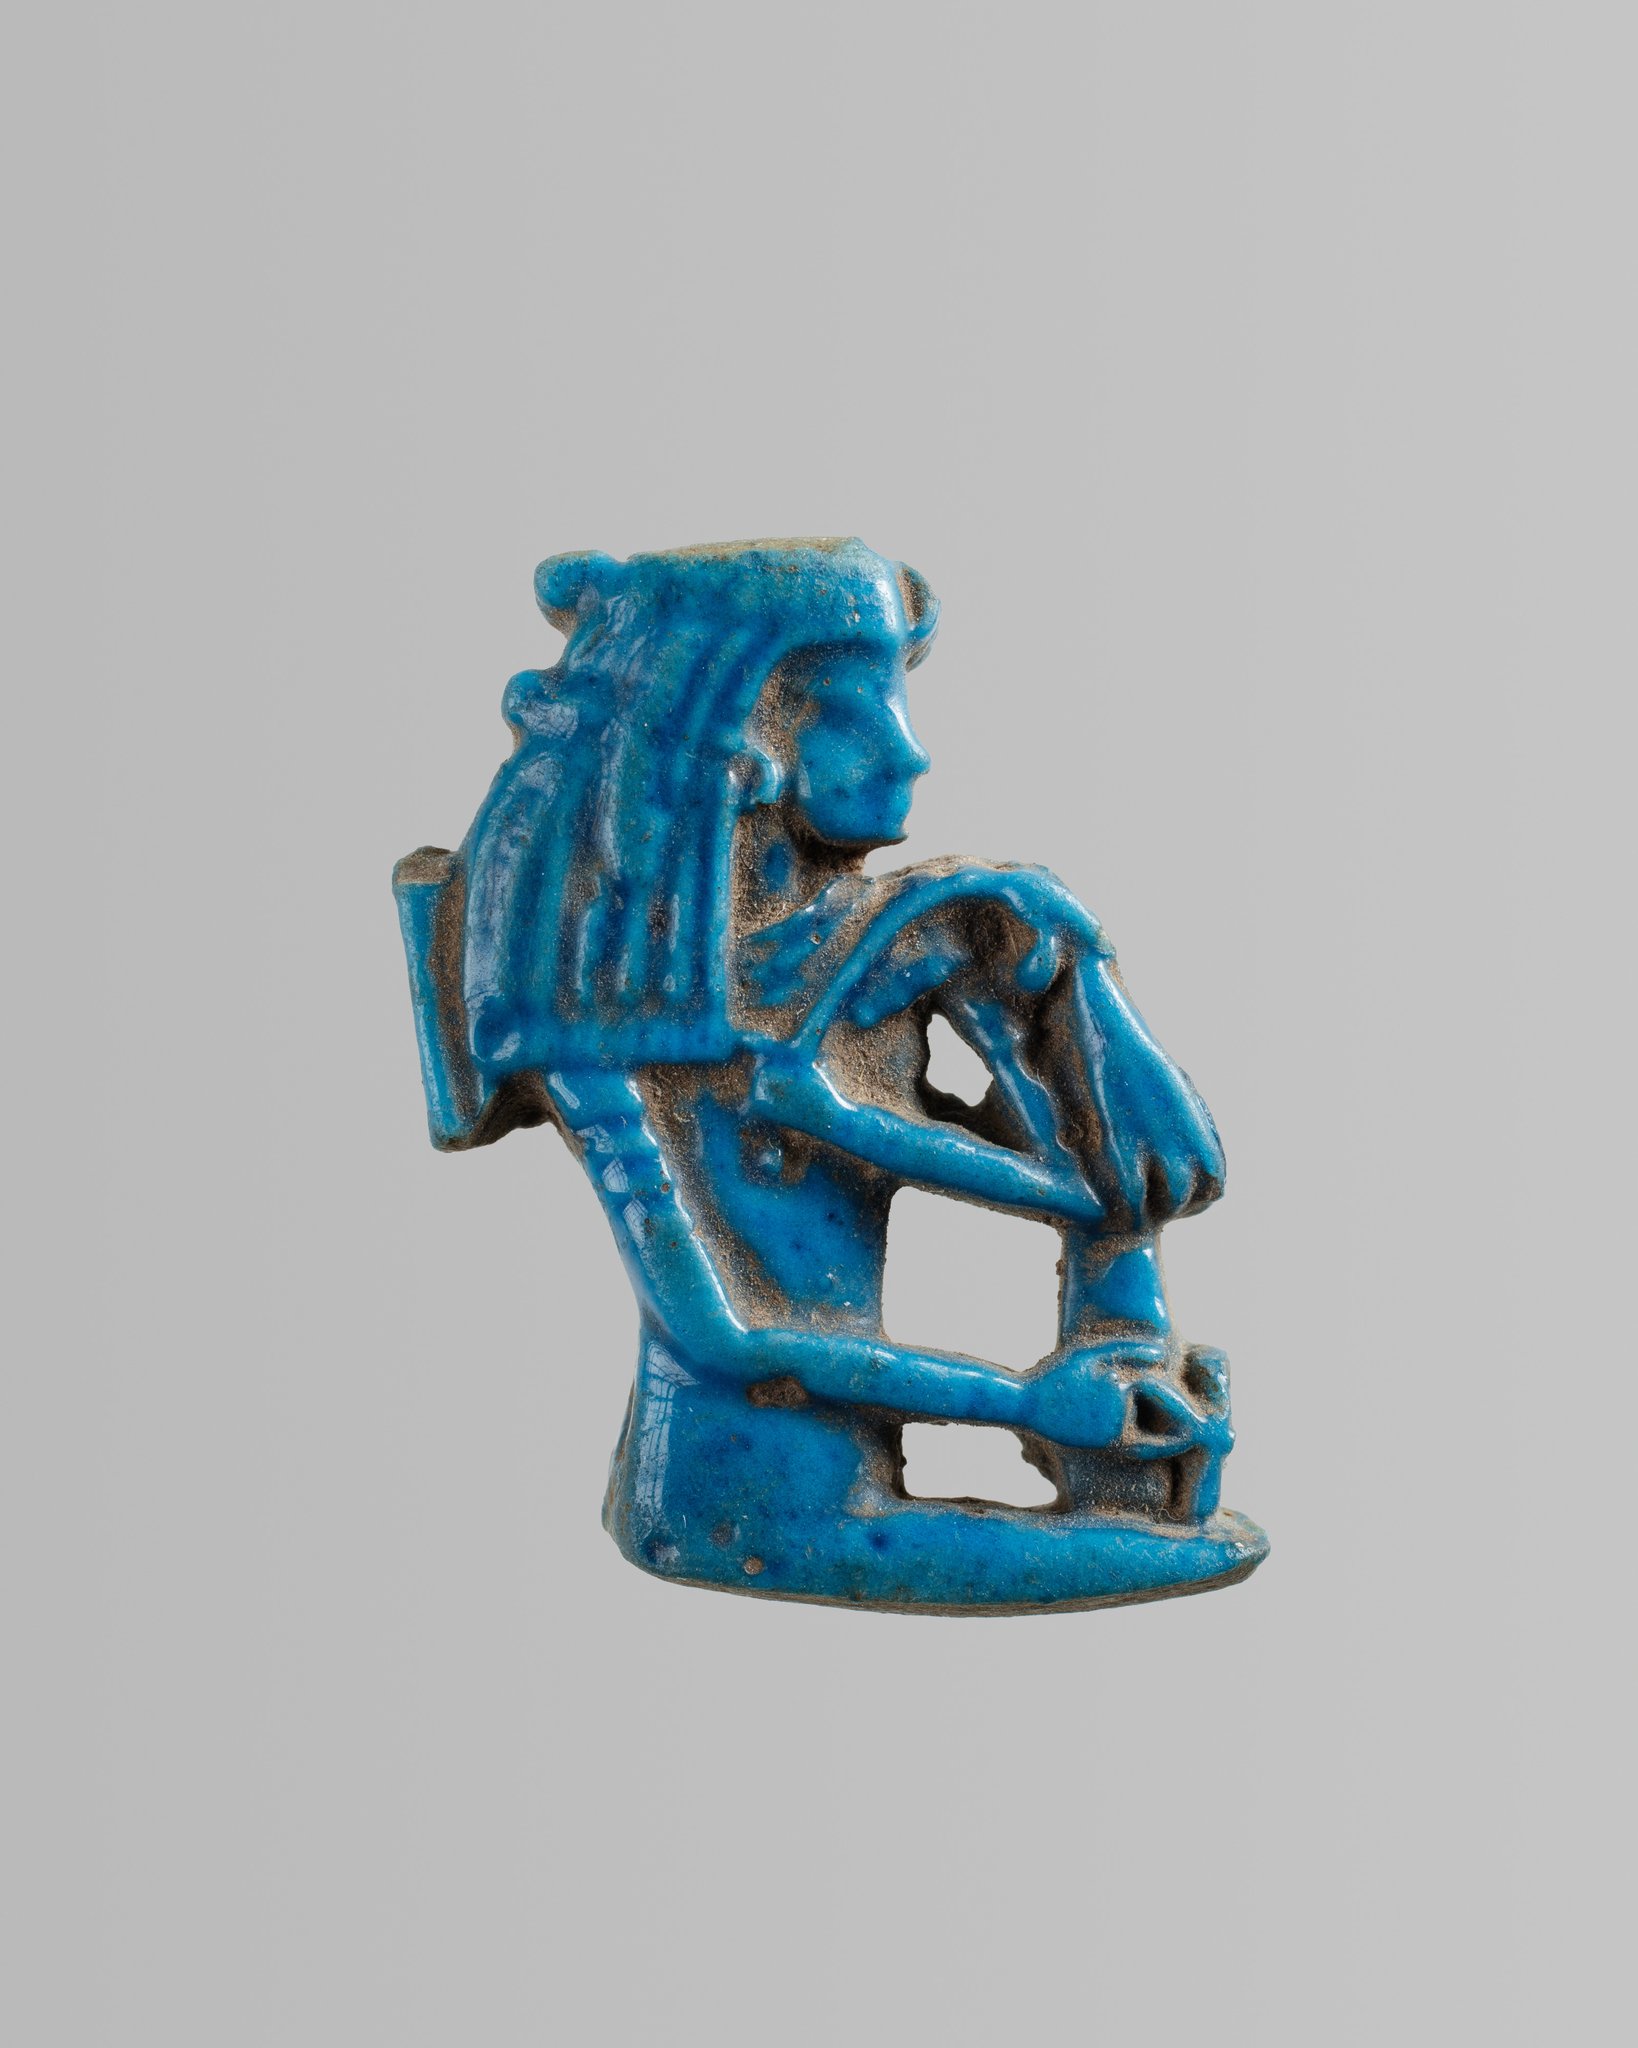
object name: amulet, queen goddess with ankh, flail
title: Amulet of seated goddess / queen with ankh and flail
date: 1390-1295 BCE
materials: faience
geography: egypt